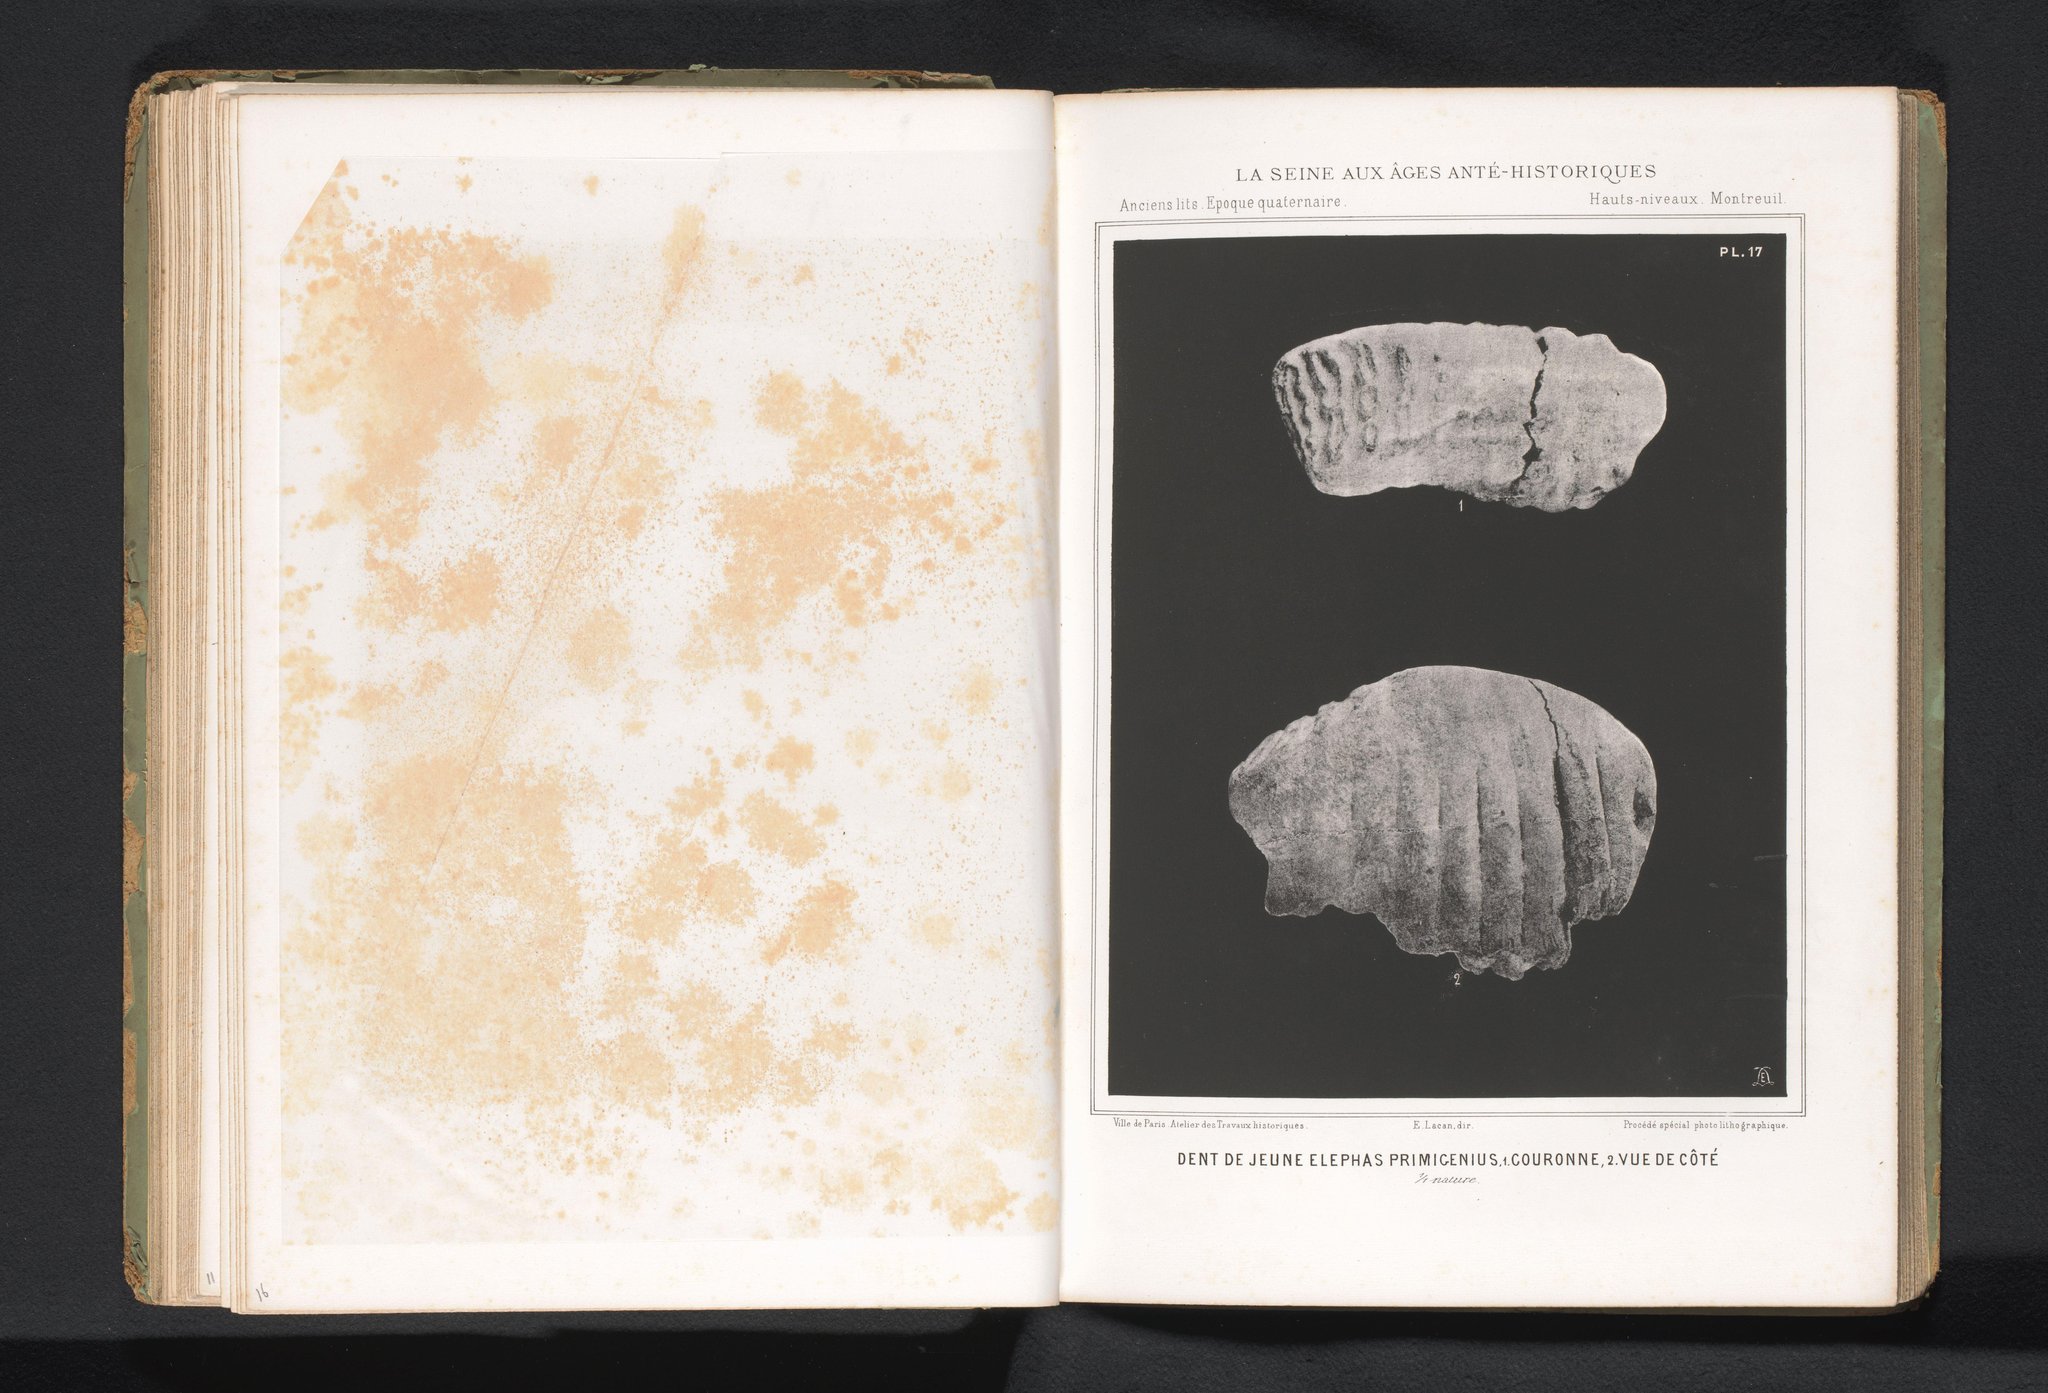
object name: photomechanical print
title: Twee aanzichten van een kies van een wolharige mammoet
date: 1864-1869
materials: paper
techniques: photolithography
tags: palaeontology, trunked animals (+ skeleton of an animal)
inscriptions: monogram: ‘E’, inscription: ‘DENT DE JEUNE ELEPHAS PRIMIGENIUS. 1. COURONNE, 2. VUE DE CÔTÉ’, inscription: ‘PL. 17’, inscription: ‘1/1 nature’, inscription: ‘Procedé spécial photo-lithographique’